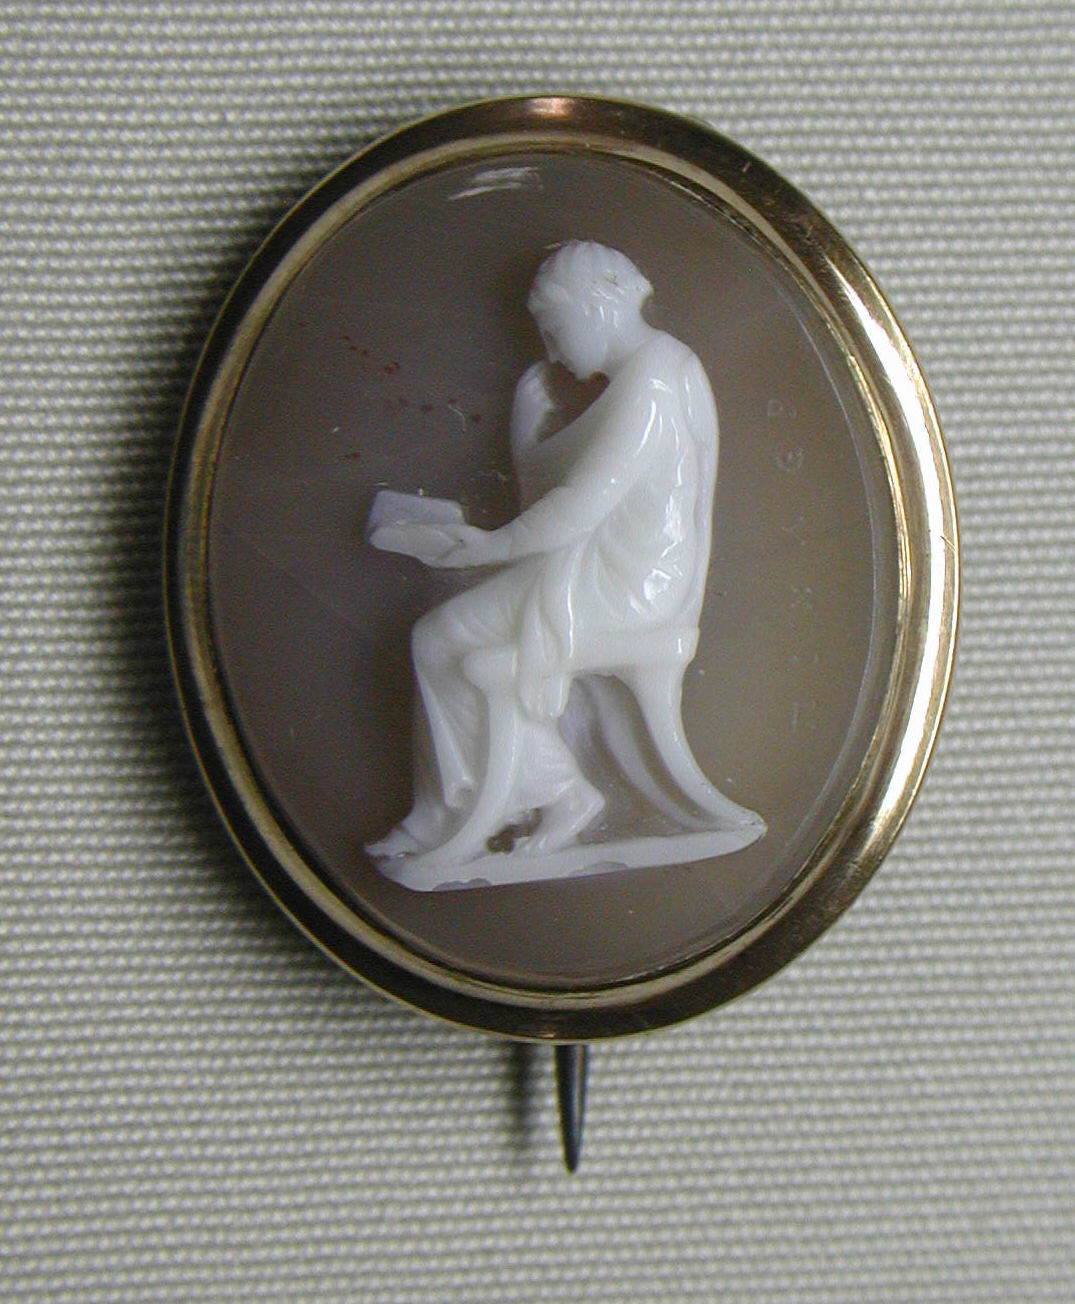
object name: cameo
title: Seated female figure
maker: giovanni pichler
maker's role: artist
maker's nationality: italian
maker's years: 1734-1791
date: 1701-1800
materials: gold, gemstone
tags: women